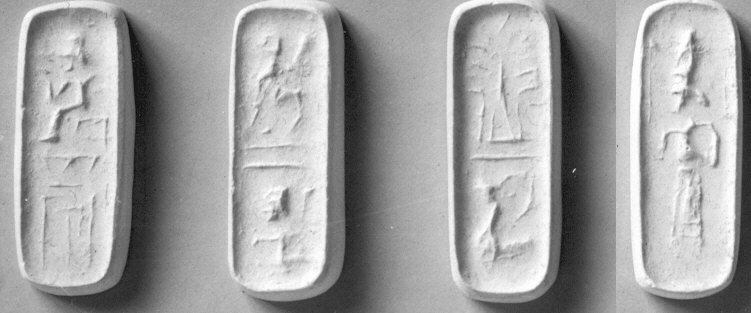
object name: stamp seal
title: Stamp seal (cubical) with animals, monsters, and anthropomorphic figures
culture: phoenician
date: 900-601 BCE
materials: stone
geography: syria or anatolia (?)